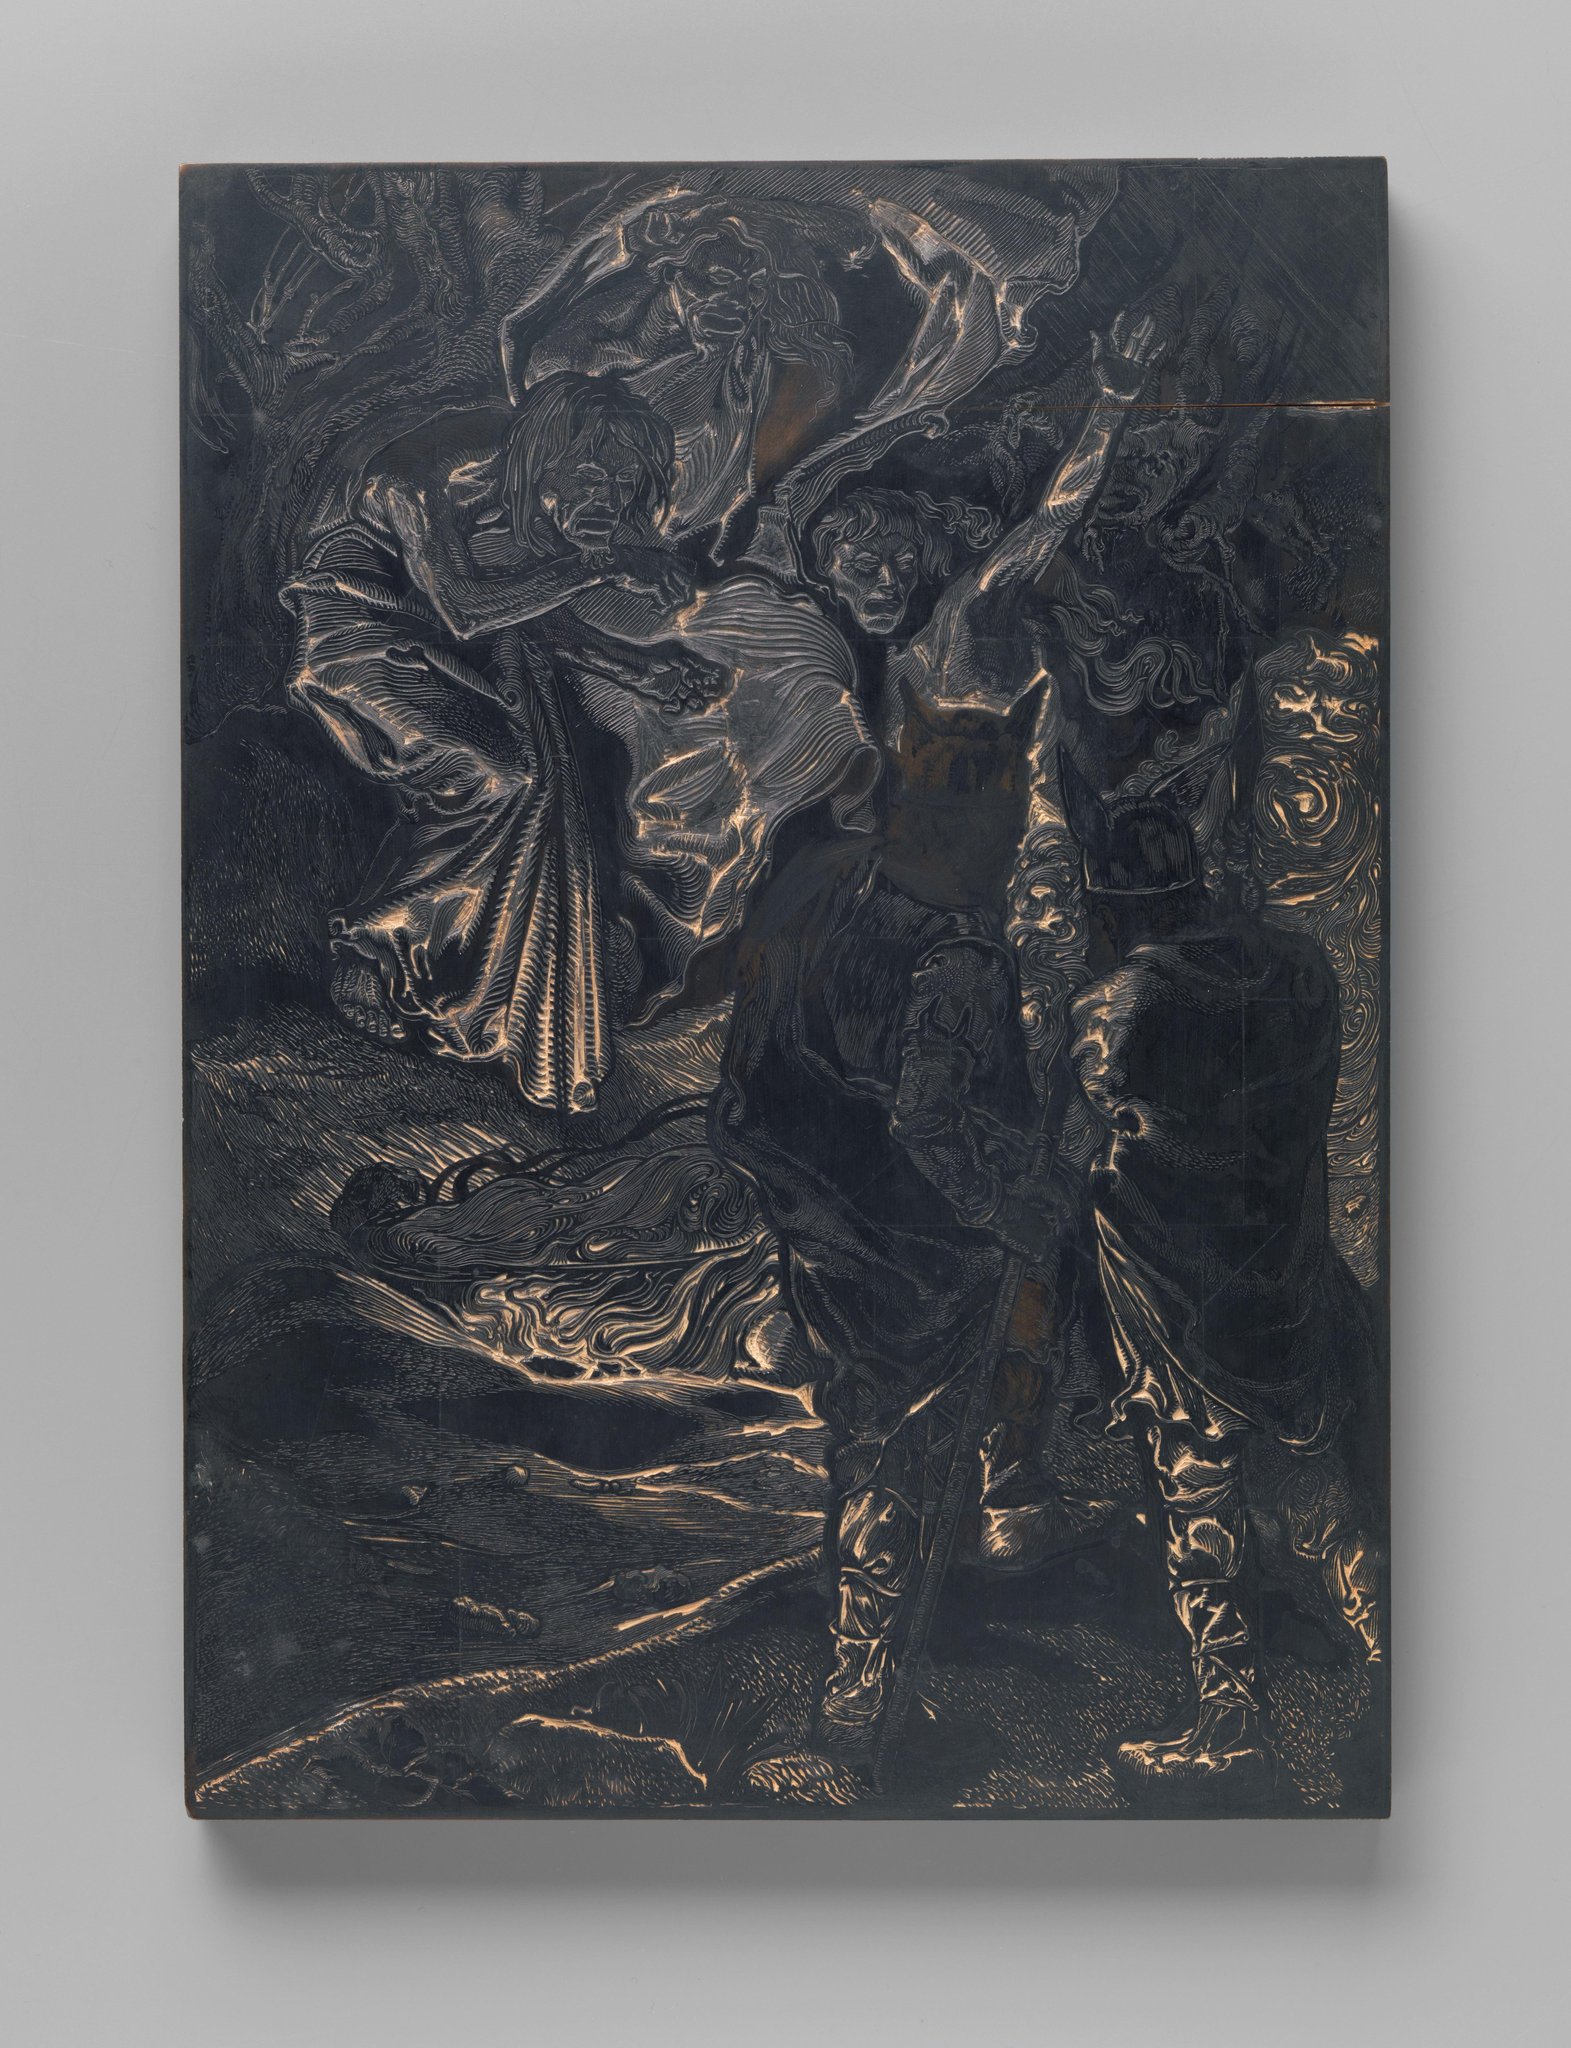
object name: wood block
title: Macbeth en Banquo ontmoeten de drie heksen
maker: johannes josephus aarts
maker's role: draughtsman, print maker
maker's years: 1871-1934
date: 1917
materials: wood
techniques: woodcut